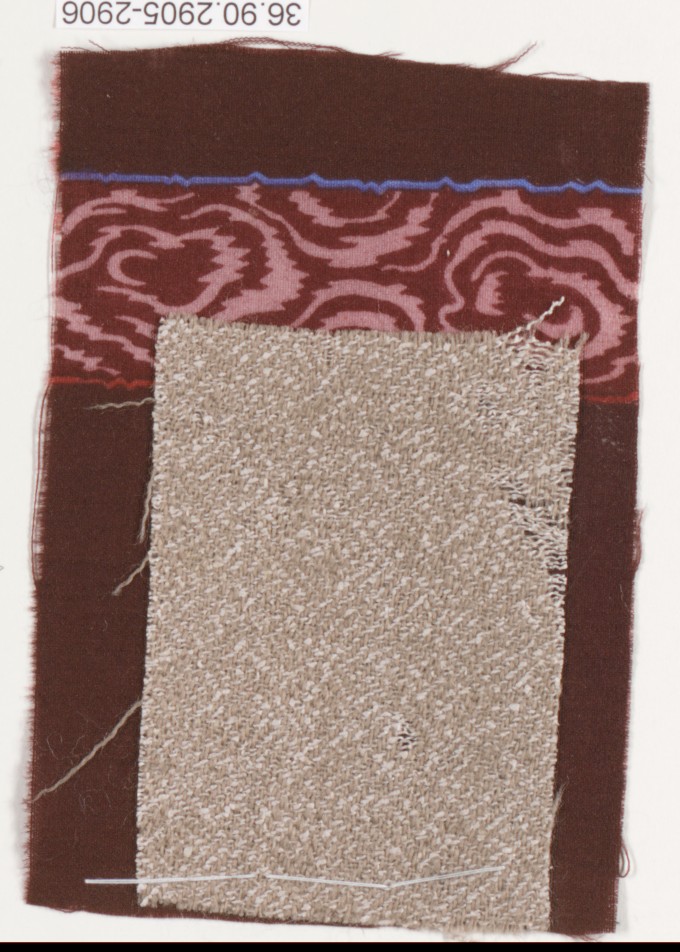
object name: piece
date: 1801-1900